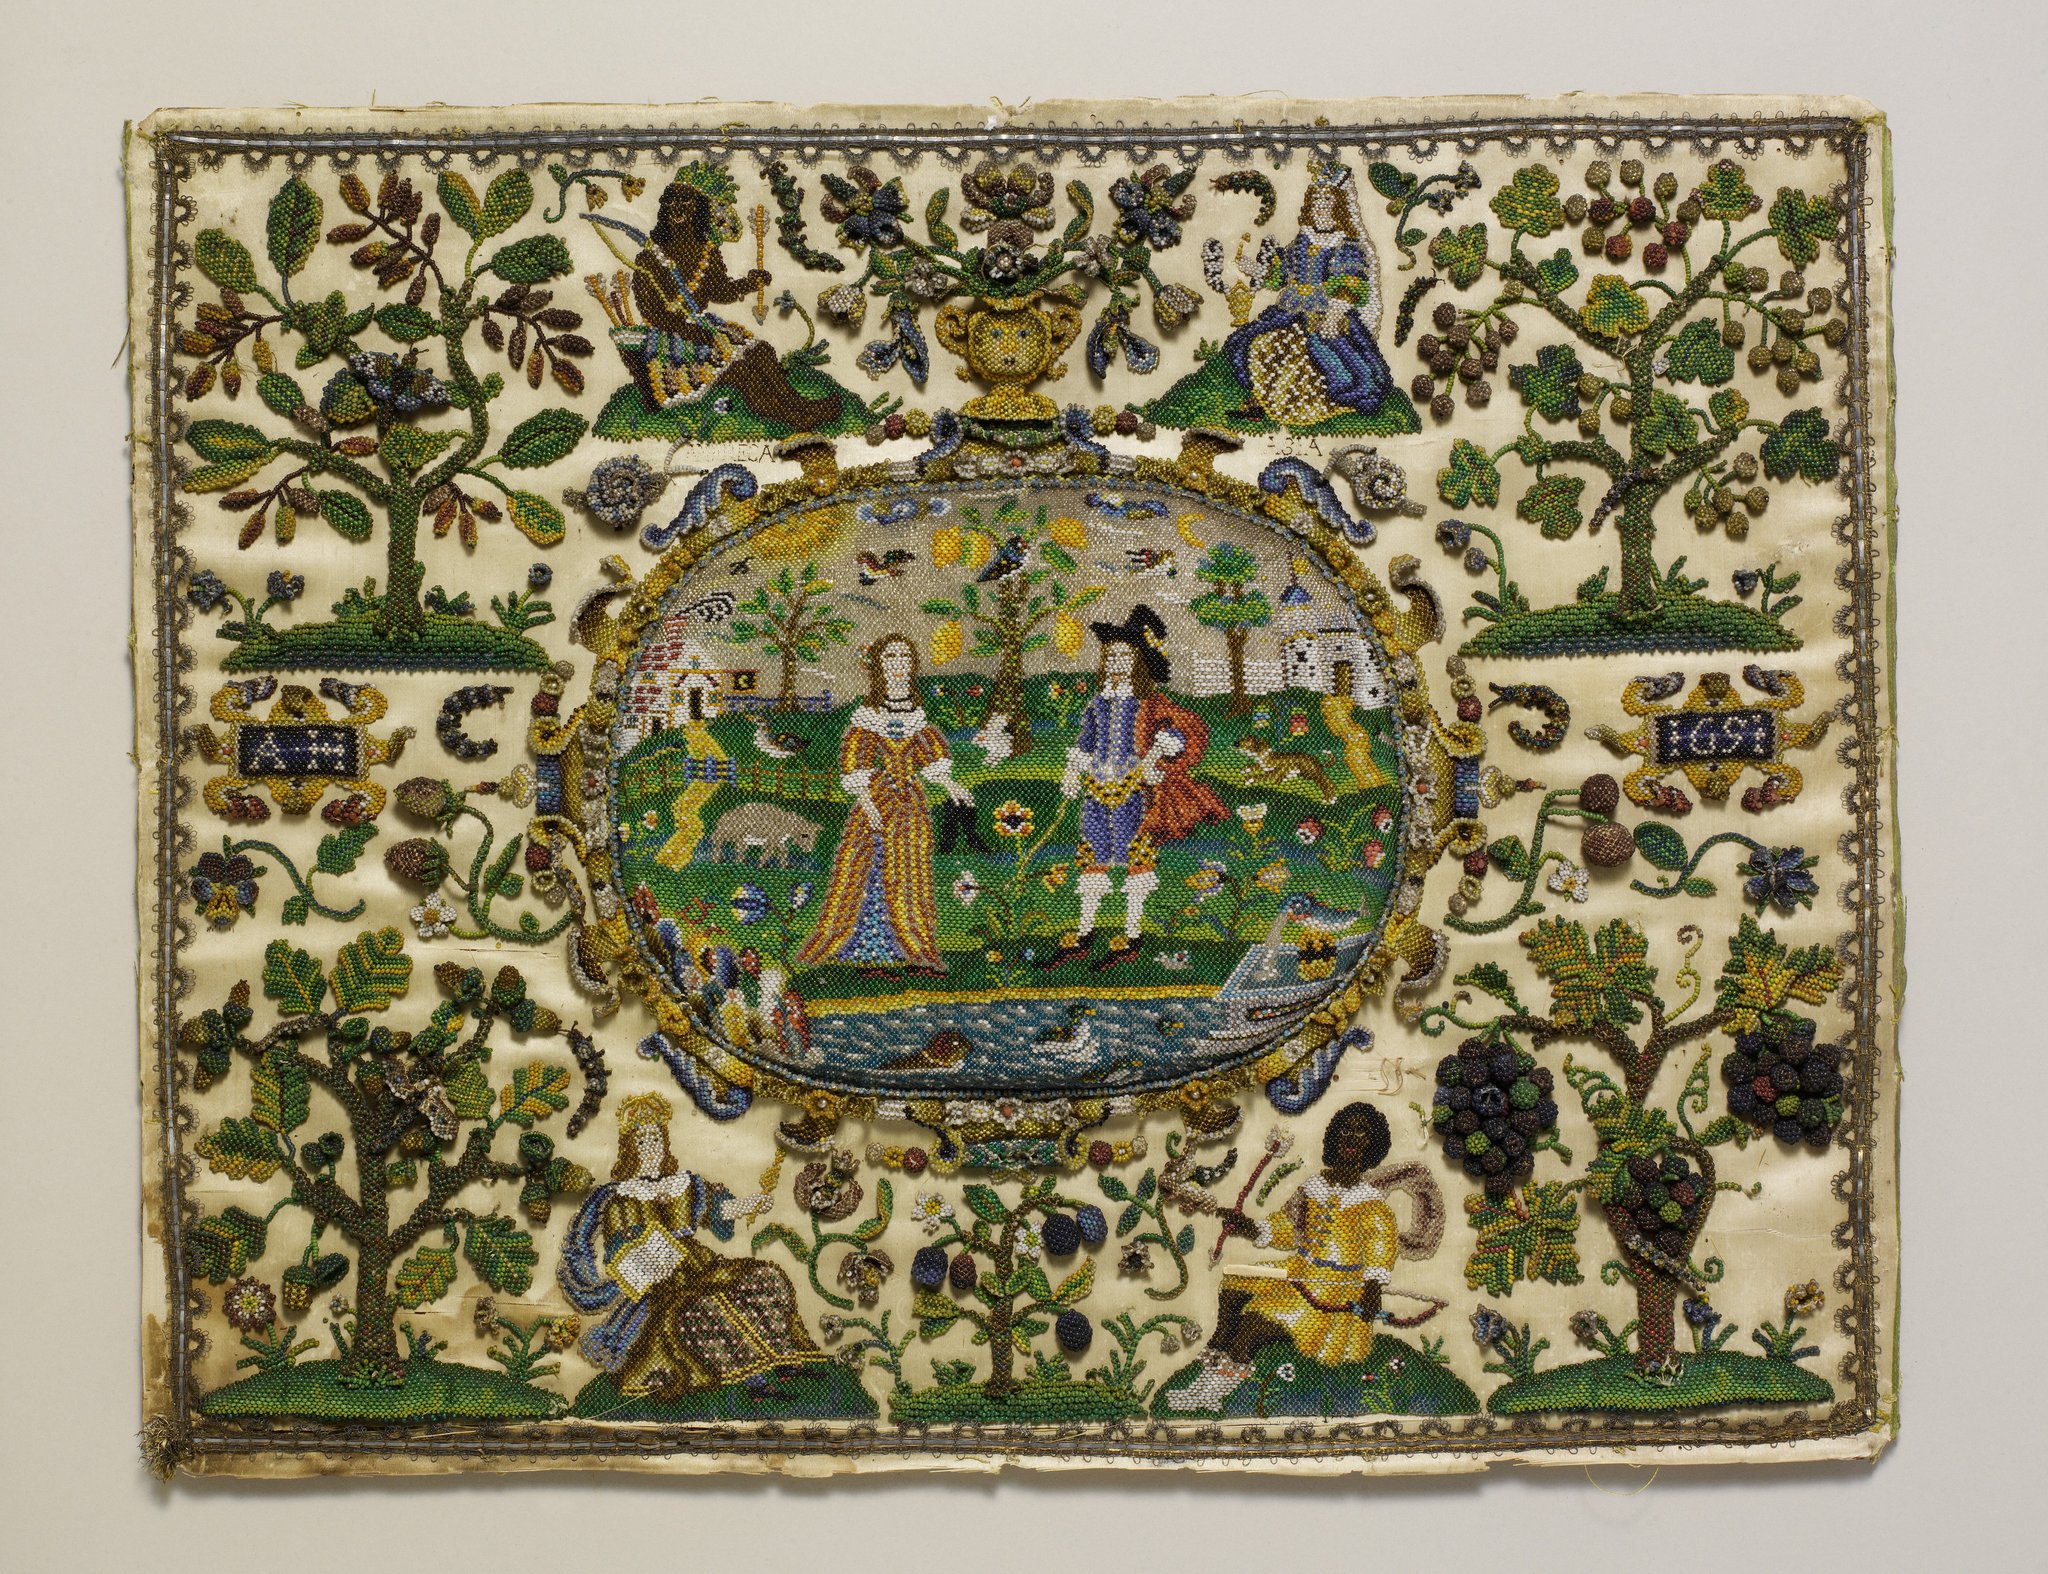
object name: panel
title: Lady and cavalier surrounded by the four continents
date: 1651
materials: glass, textile, thread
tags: fruit,men,women,flowers,trees